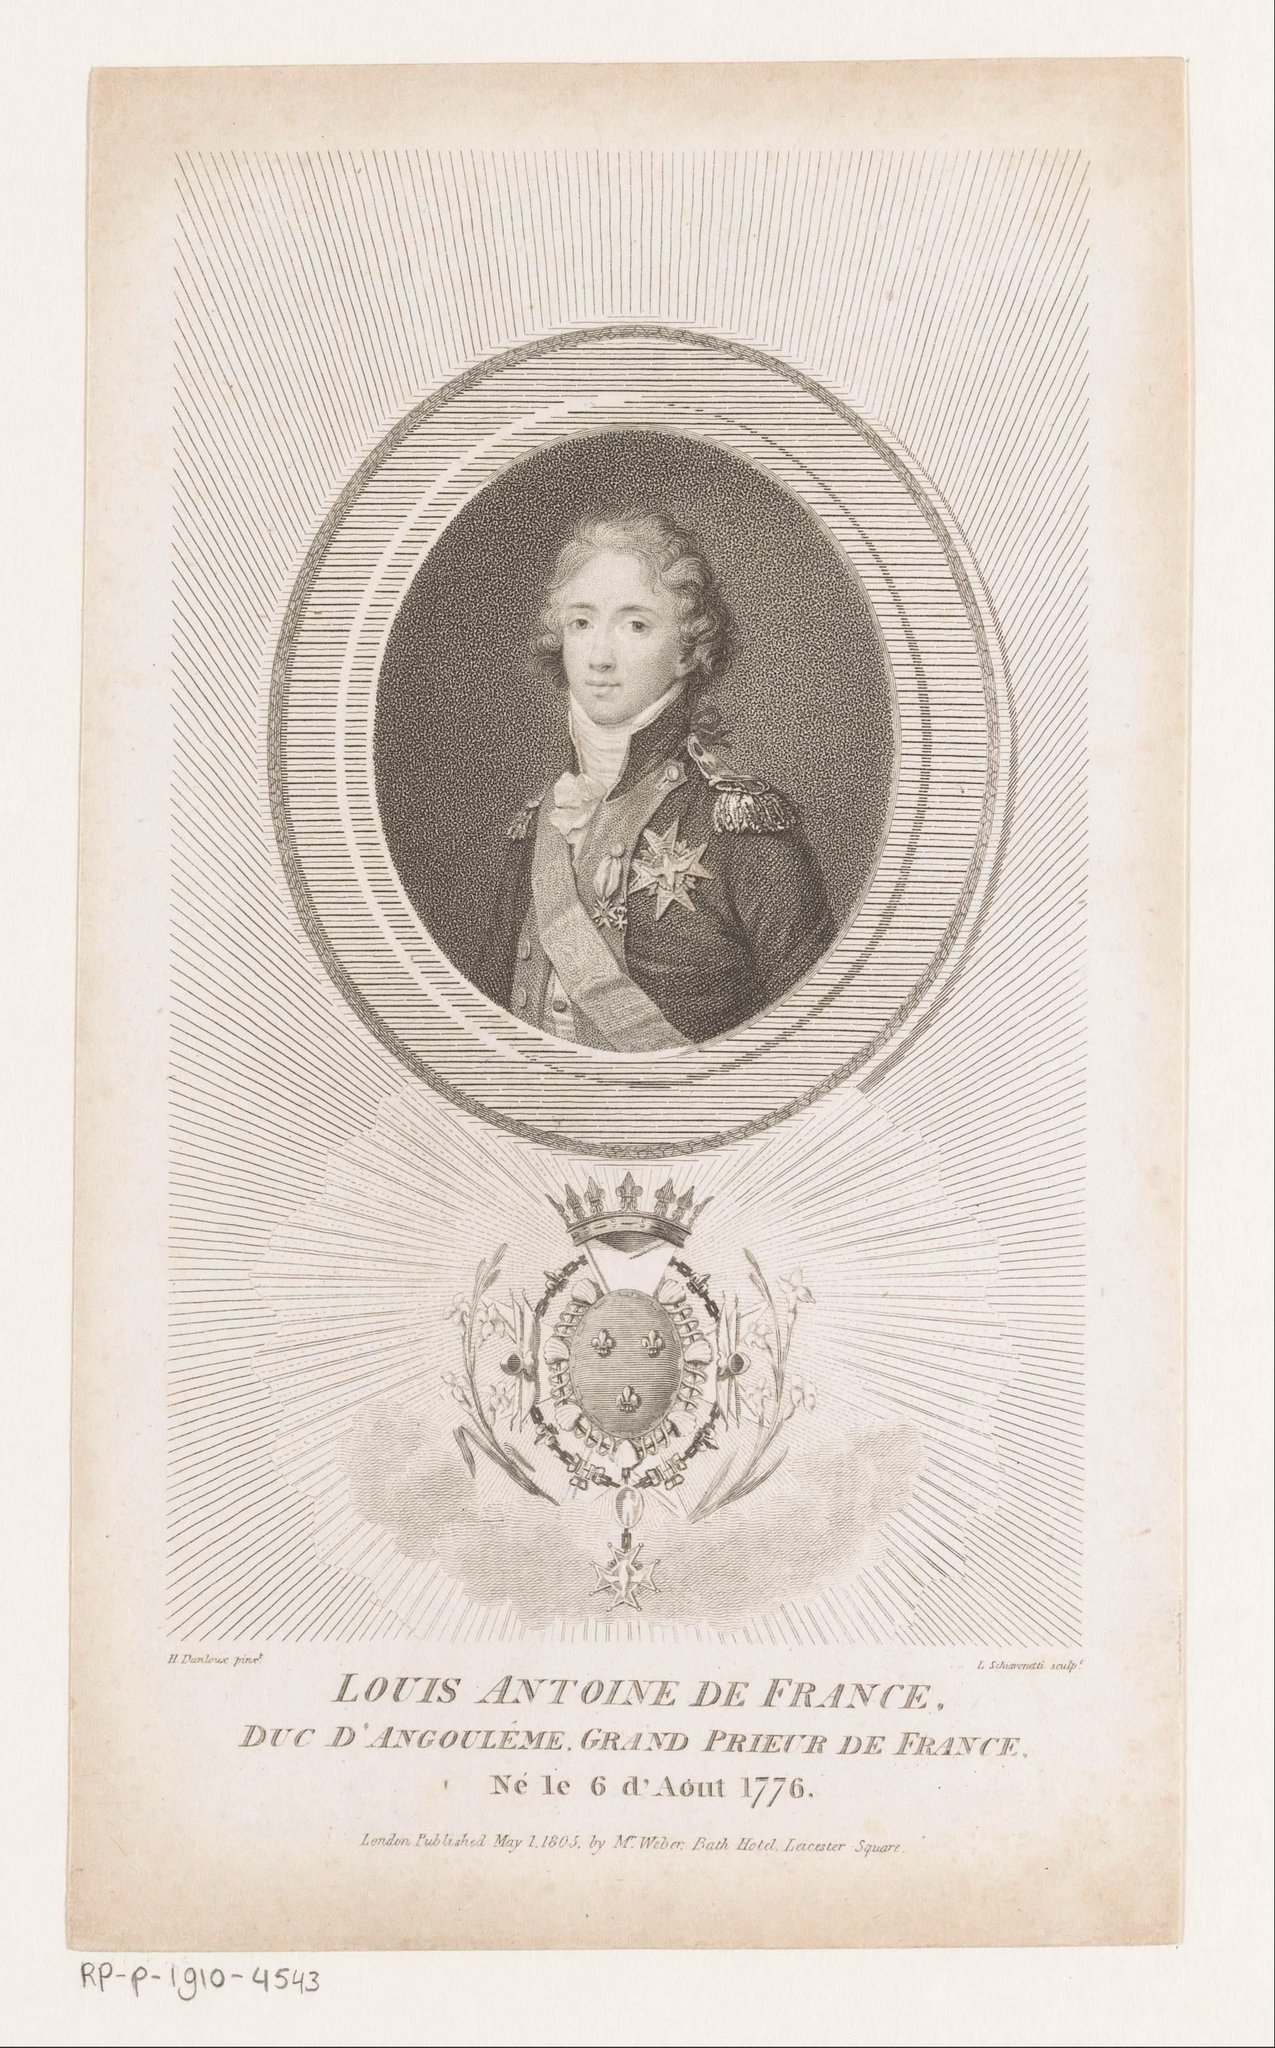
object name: print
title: Portret van hertog Lodewijk Anton van Bourbon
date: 1805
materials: paper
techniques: etching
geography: london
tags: historical persons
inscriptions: collector's mark: Lugt 2228